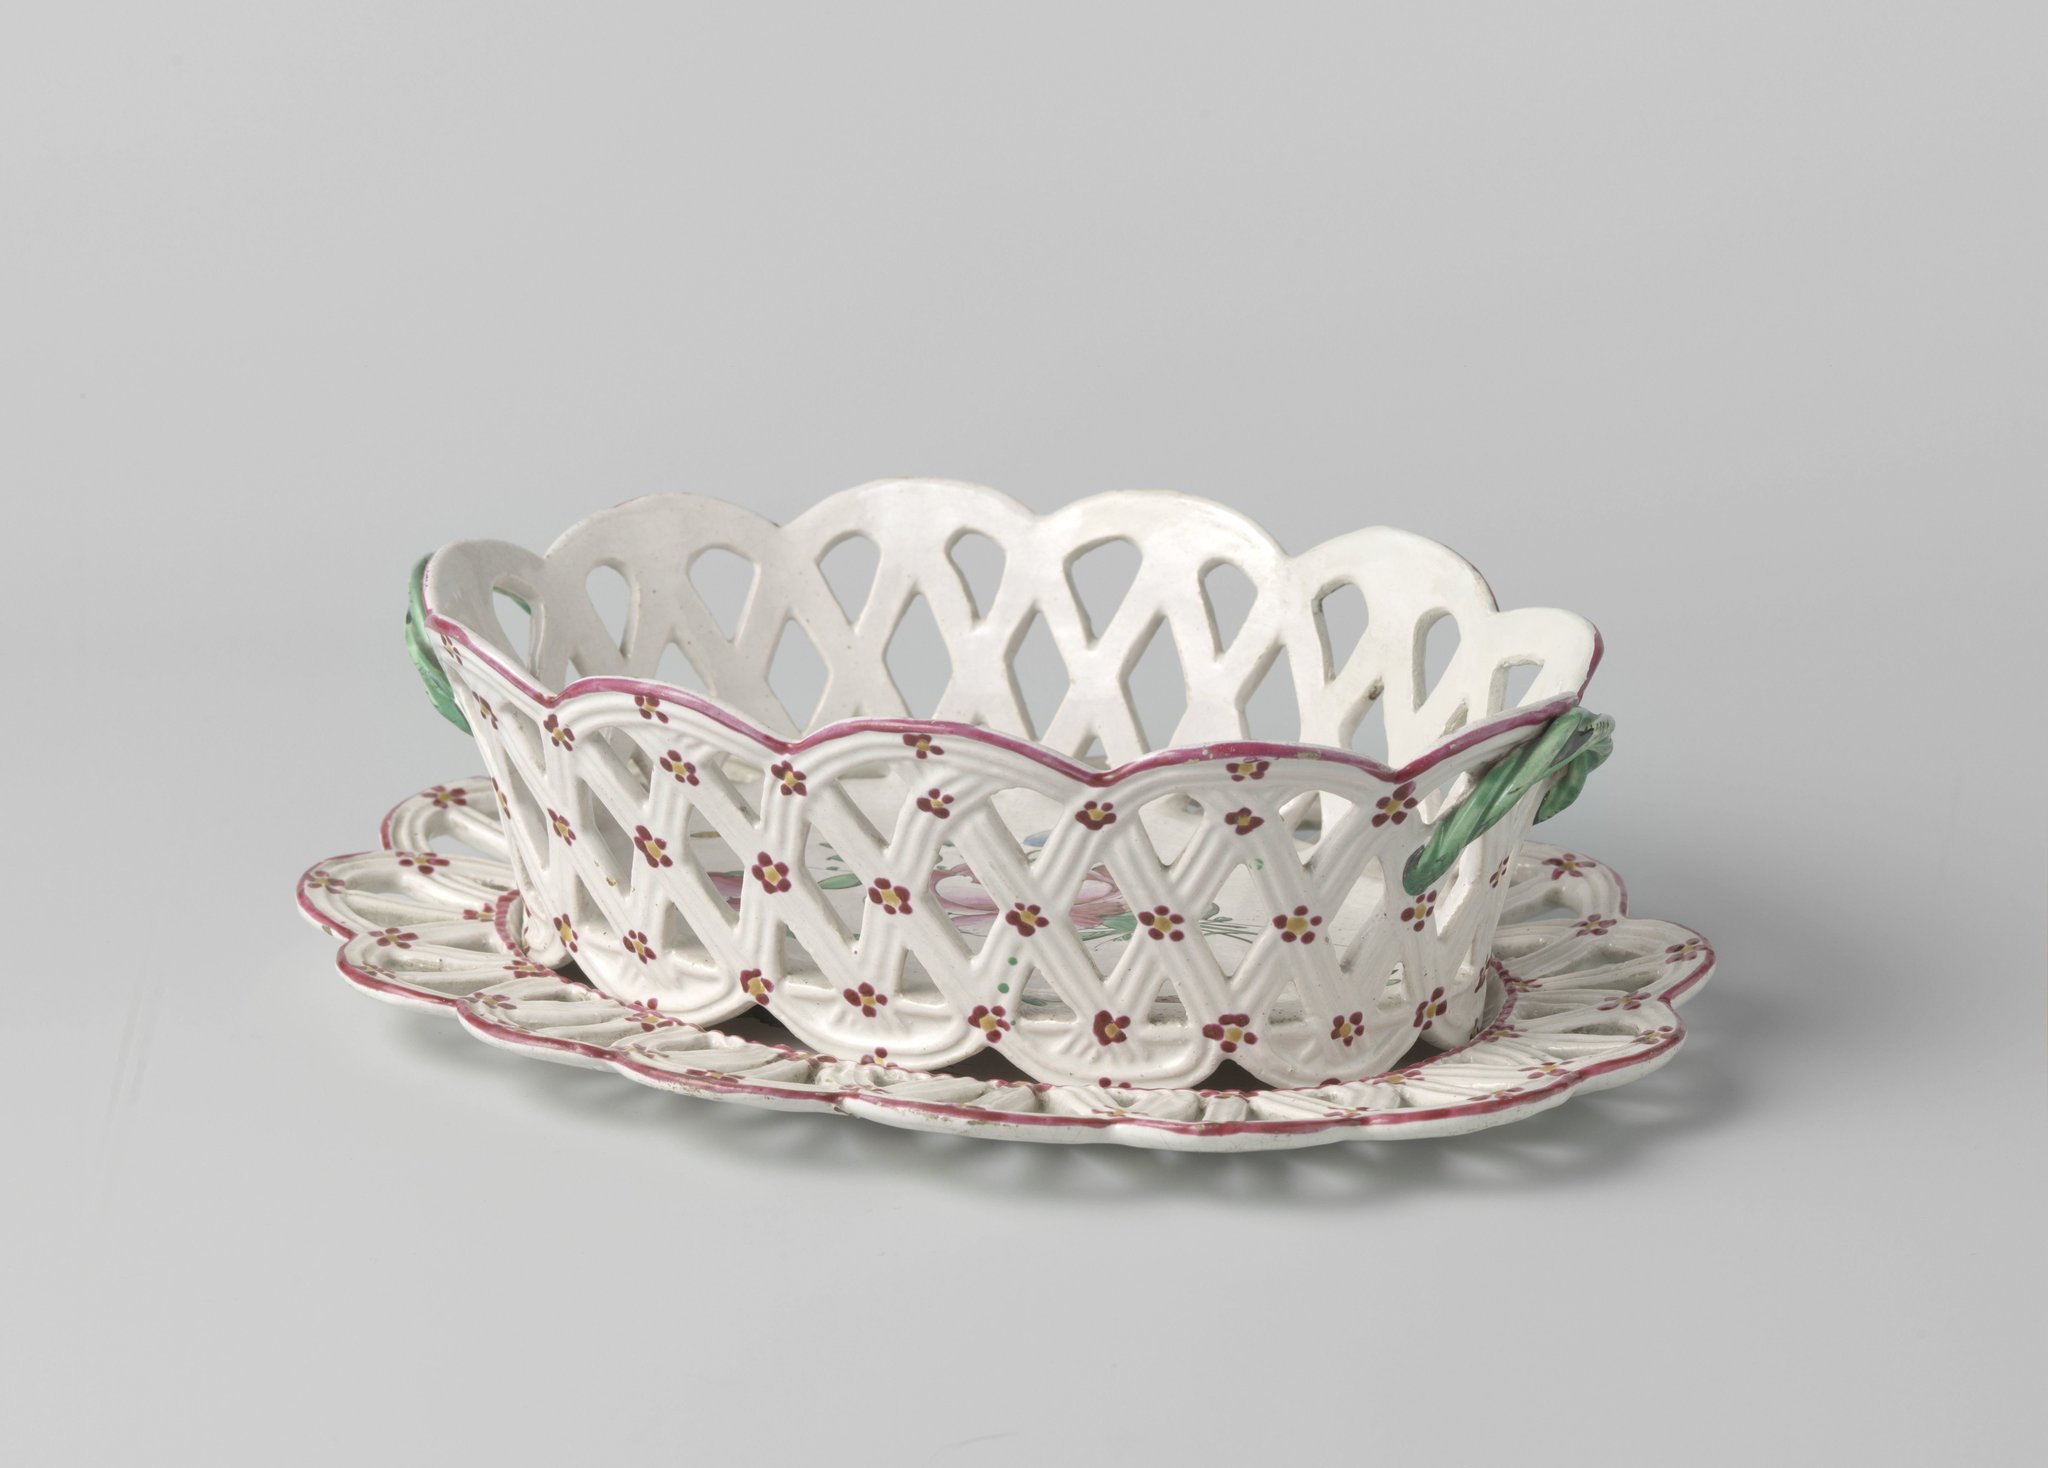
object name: platter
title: Fruitschaal op onderschotel met oren en opengewerkte wand en rand, beschilderd met bloemen en insecten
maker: Anonymous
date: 1770-1820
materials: earthenware, glaze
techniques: painted, polychromy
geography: france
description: Ovale fruitschaal op onderschotel, van veelkleurig beschilderde faience. De schaal en de schotel hebben een ruitvormig opengewerkte wand en rand. Op de bodem van de schaal is een bloemenboeket geschilderd en drie insecten en op de buitenwand kleine bloemen en twee groene oren. Op het plat van de onderschotel is een bloemboeket geschilderd en een insect en op de rand kleine bloemen.